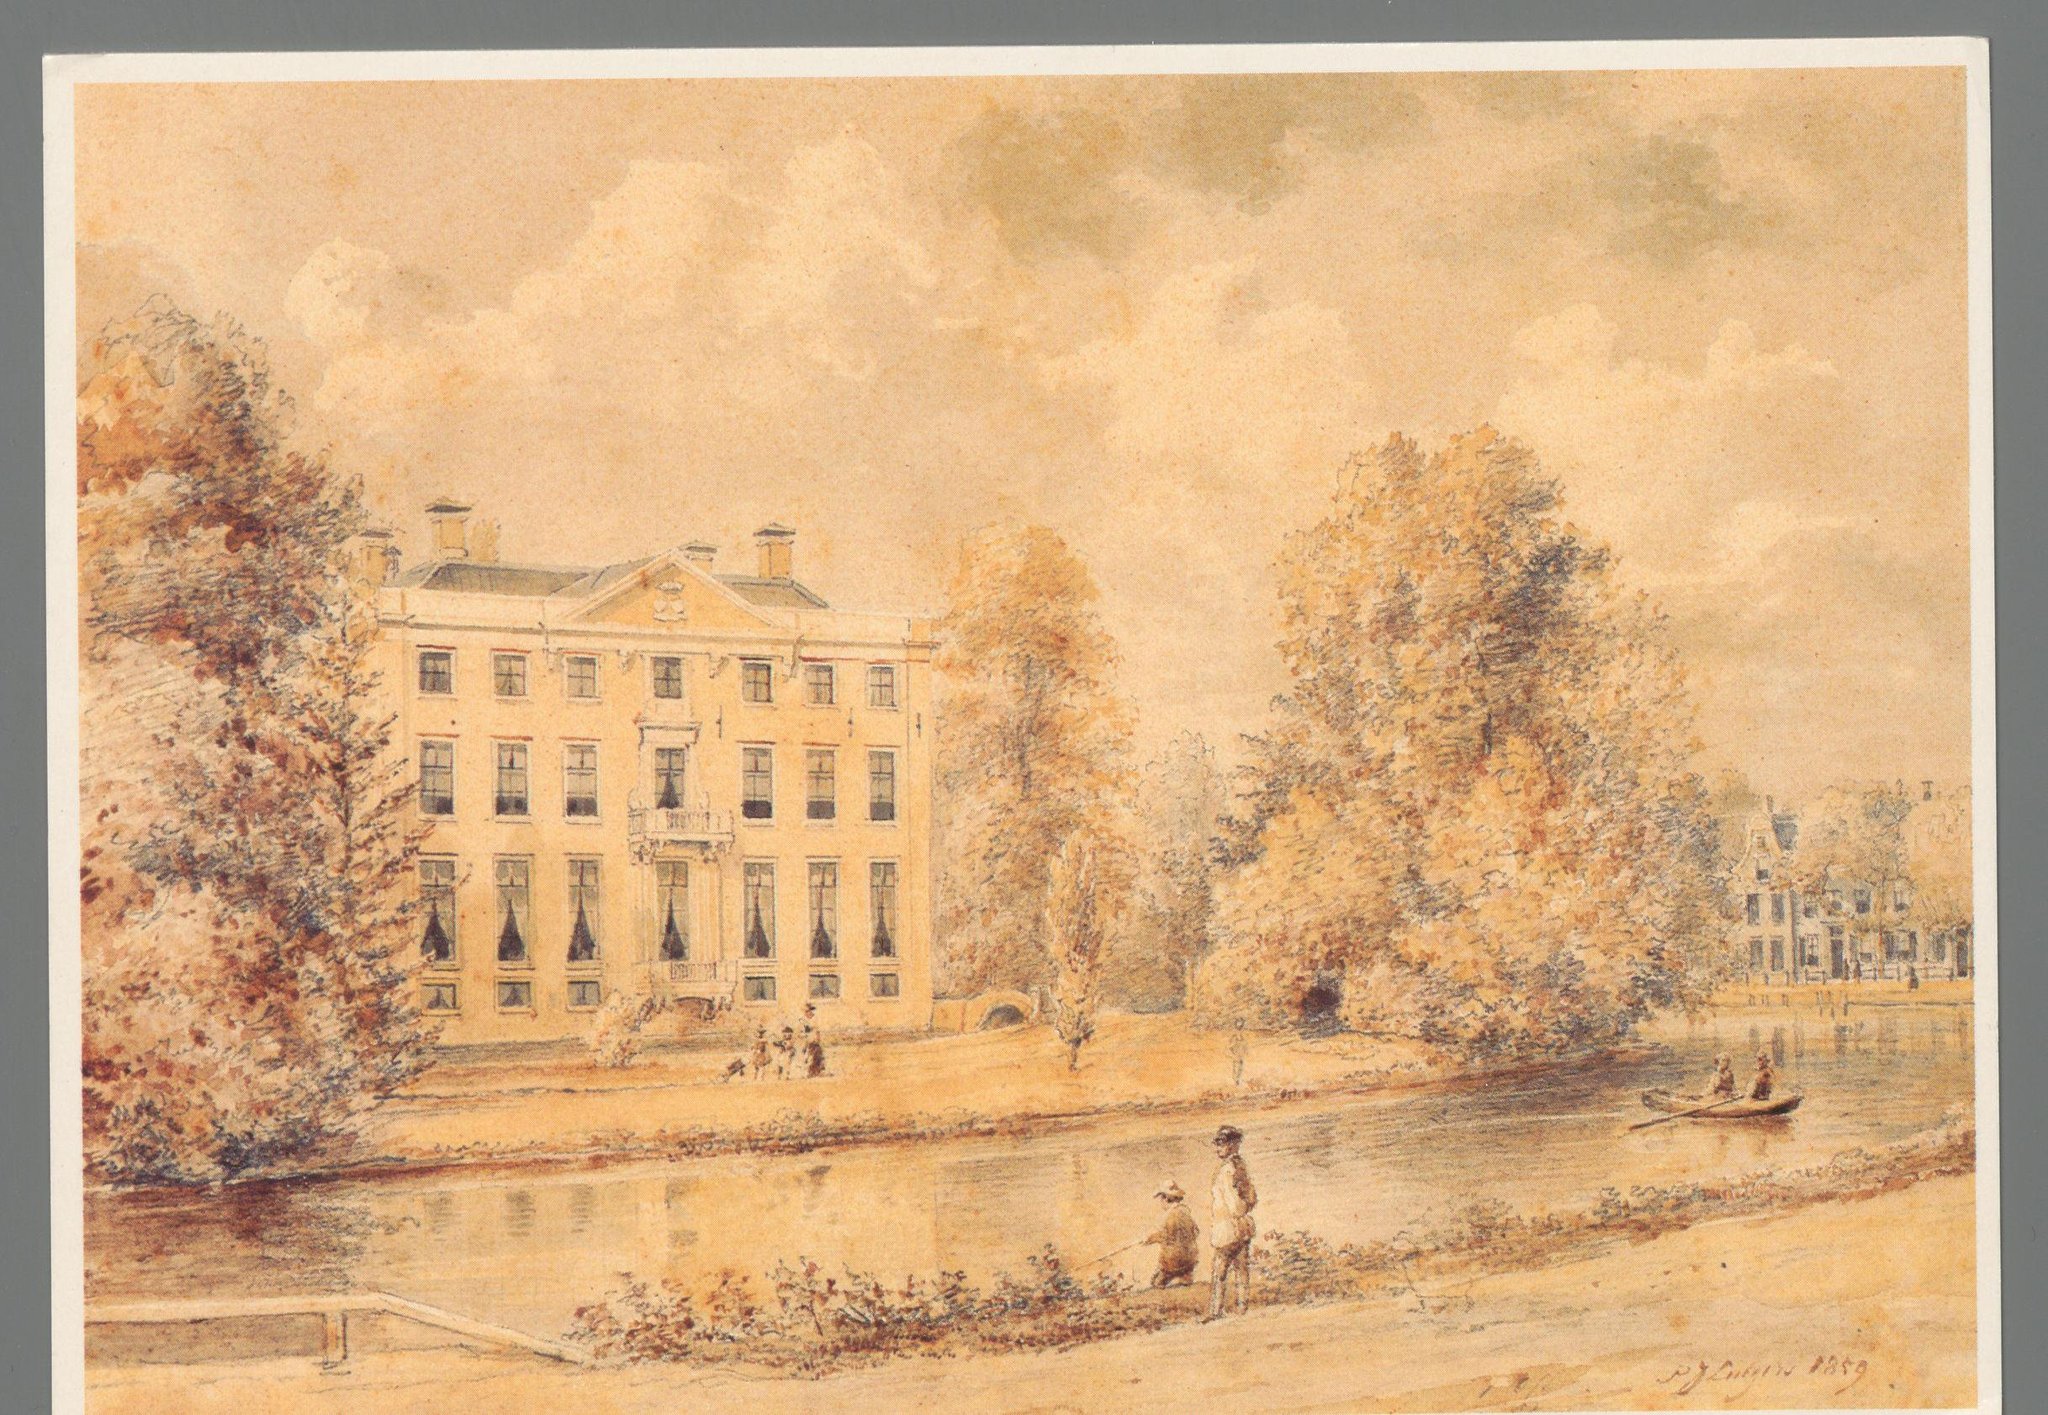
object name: photomechanical print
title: Het Huis ter Meer bij Maarssen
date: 1998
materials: cardboard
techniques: offset printed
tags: river, villa, vecht